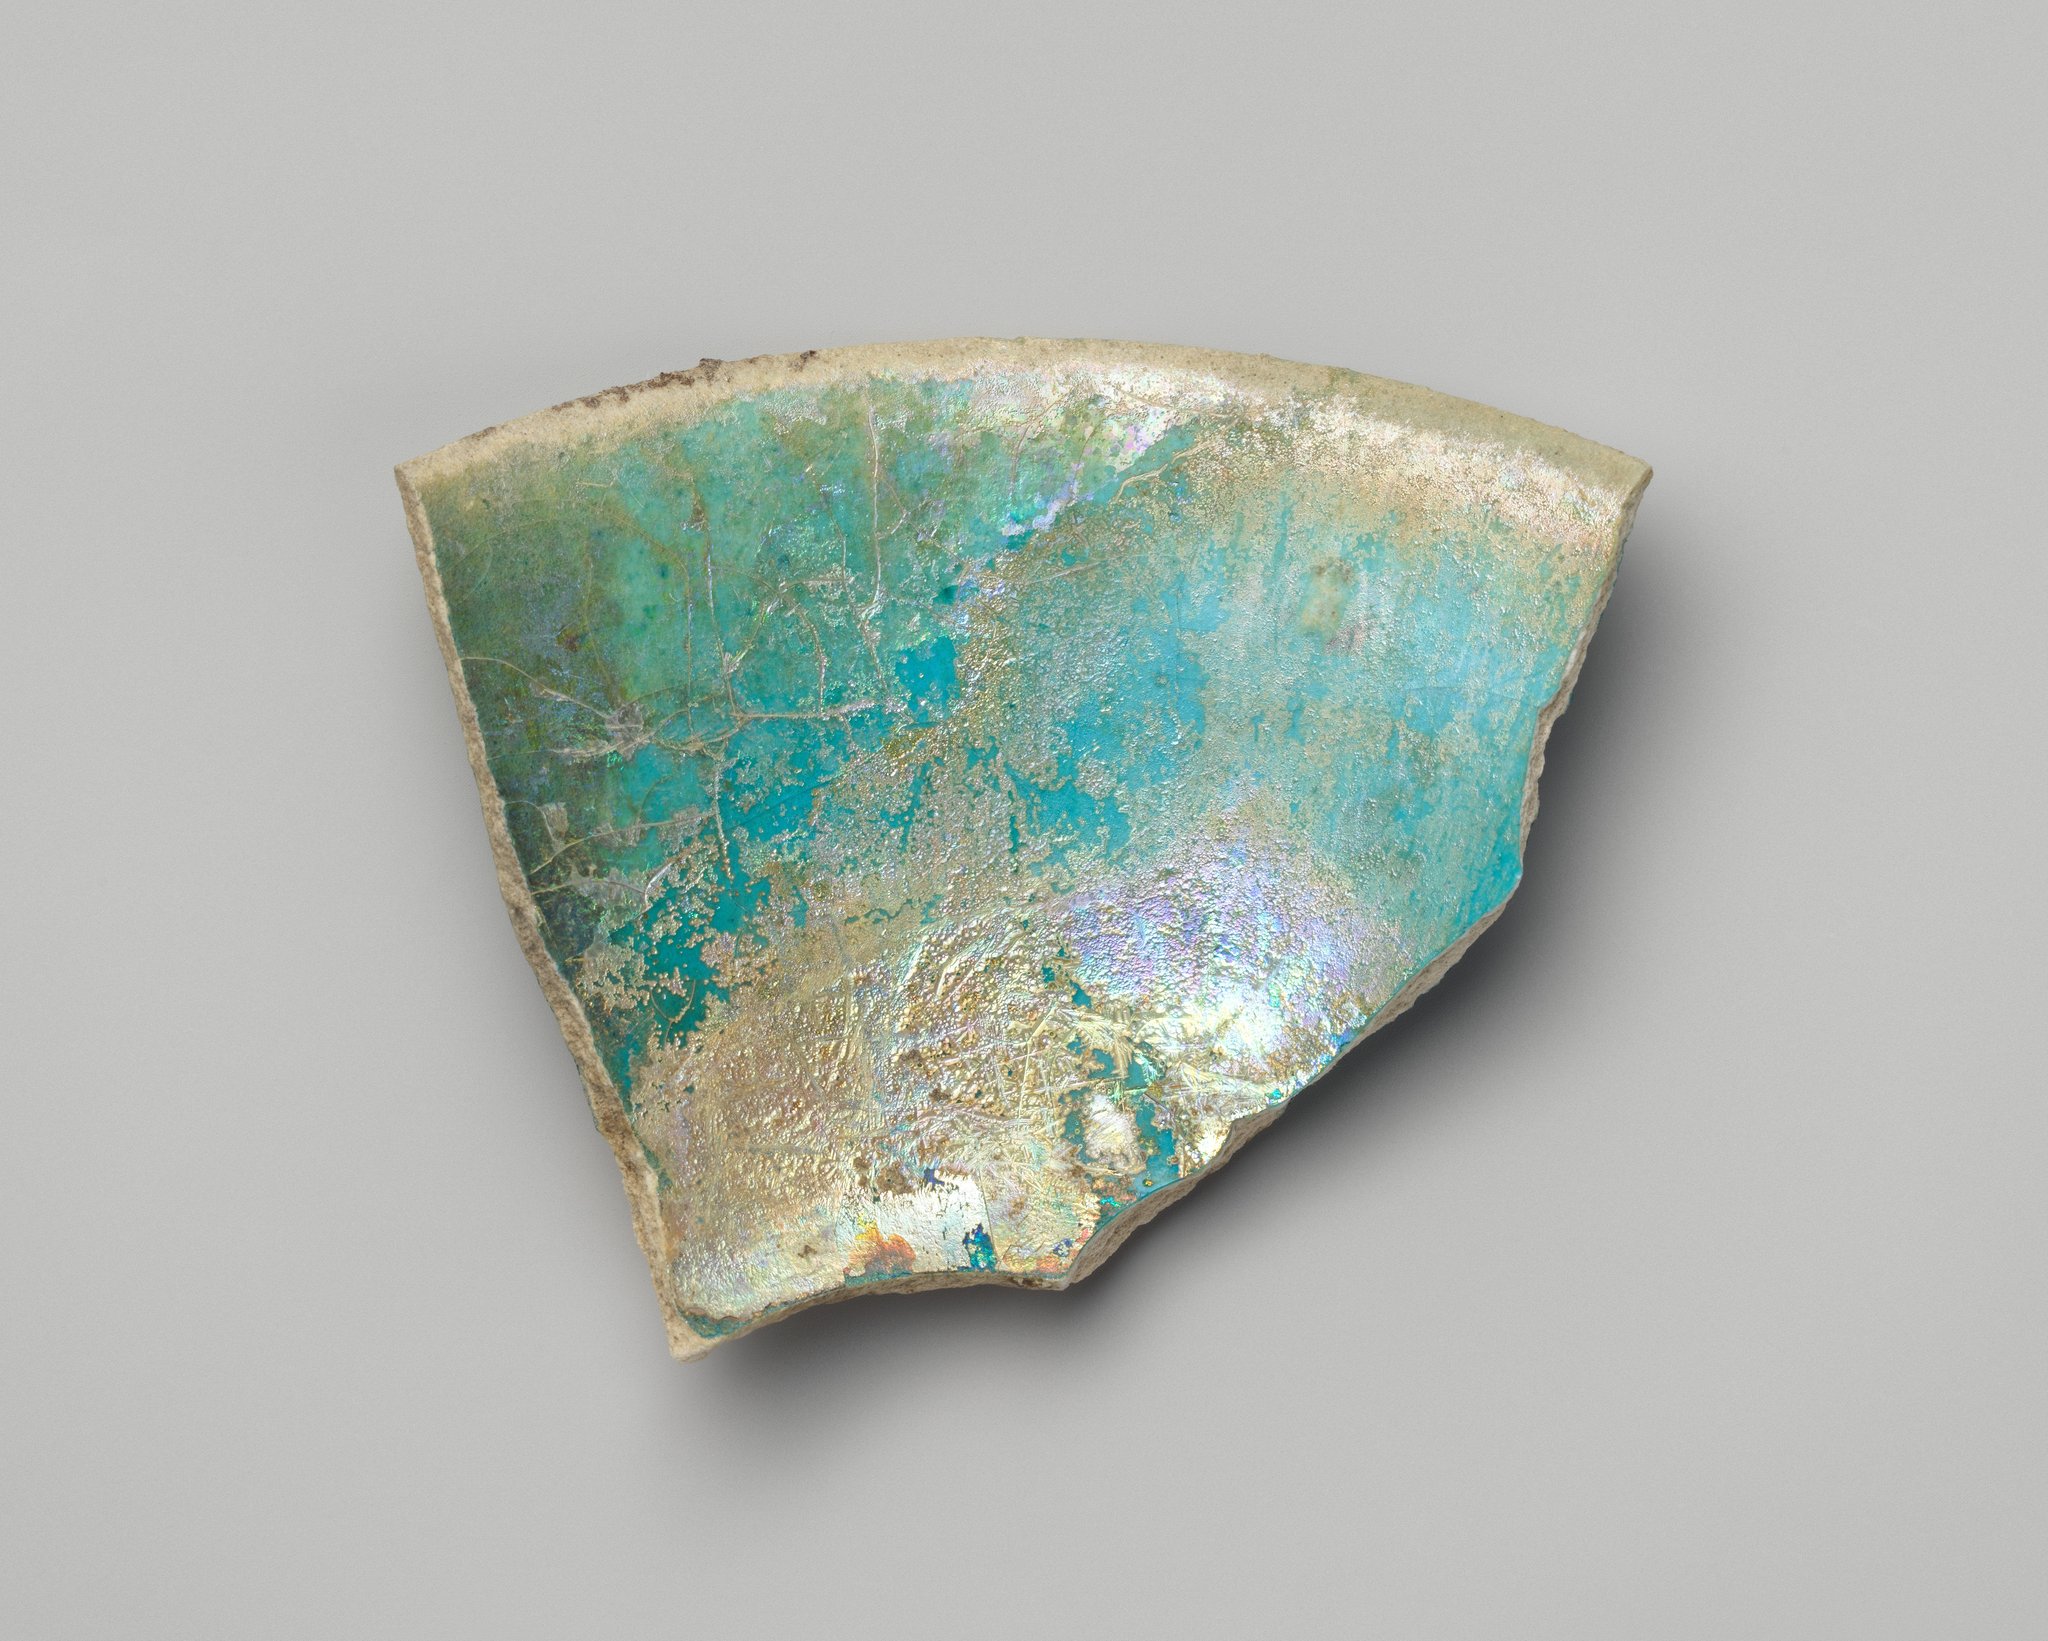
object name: fragment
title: Fragment of a Bowl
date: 1001-1200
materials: stonepaste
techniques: glazing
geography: iran